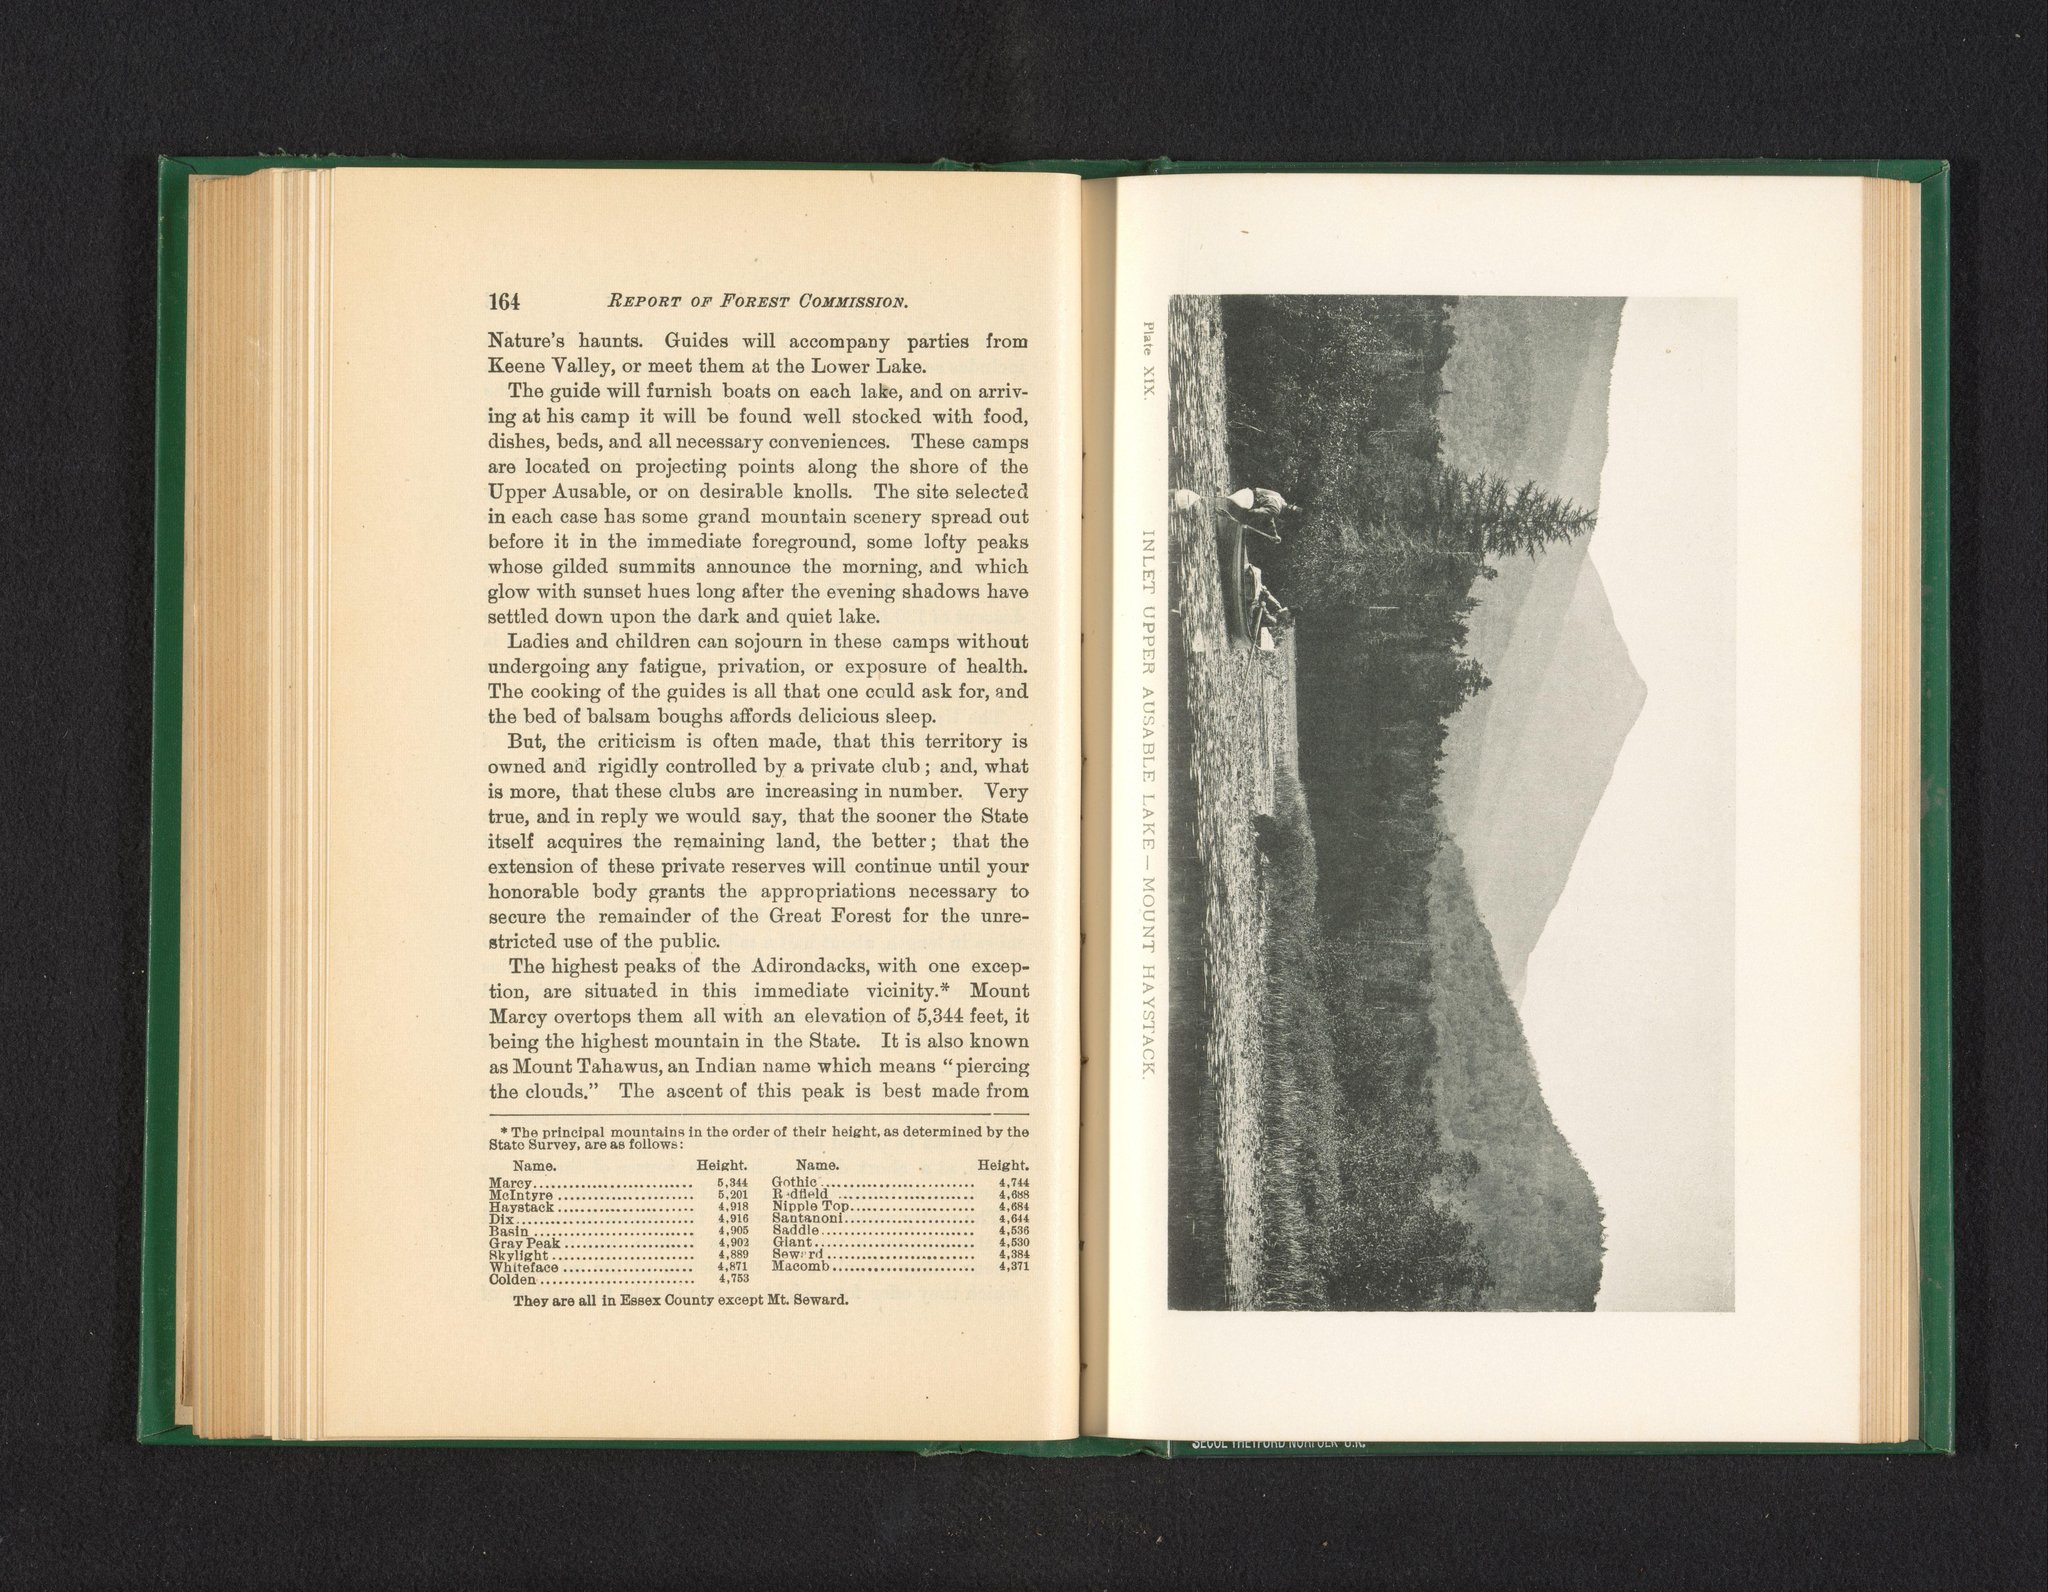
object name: page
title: Inlet Upper Ausable Lake-Mount Haystack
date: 1891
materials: paper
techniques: photograph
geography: new york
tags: mountains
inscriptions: number: ‘Plate XIX.’